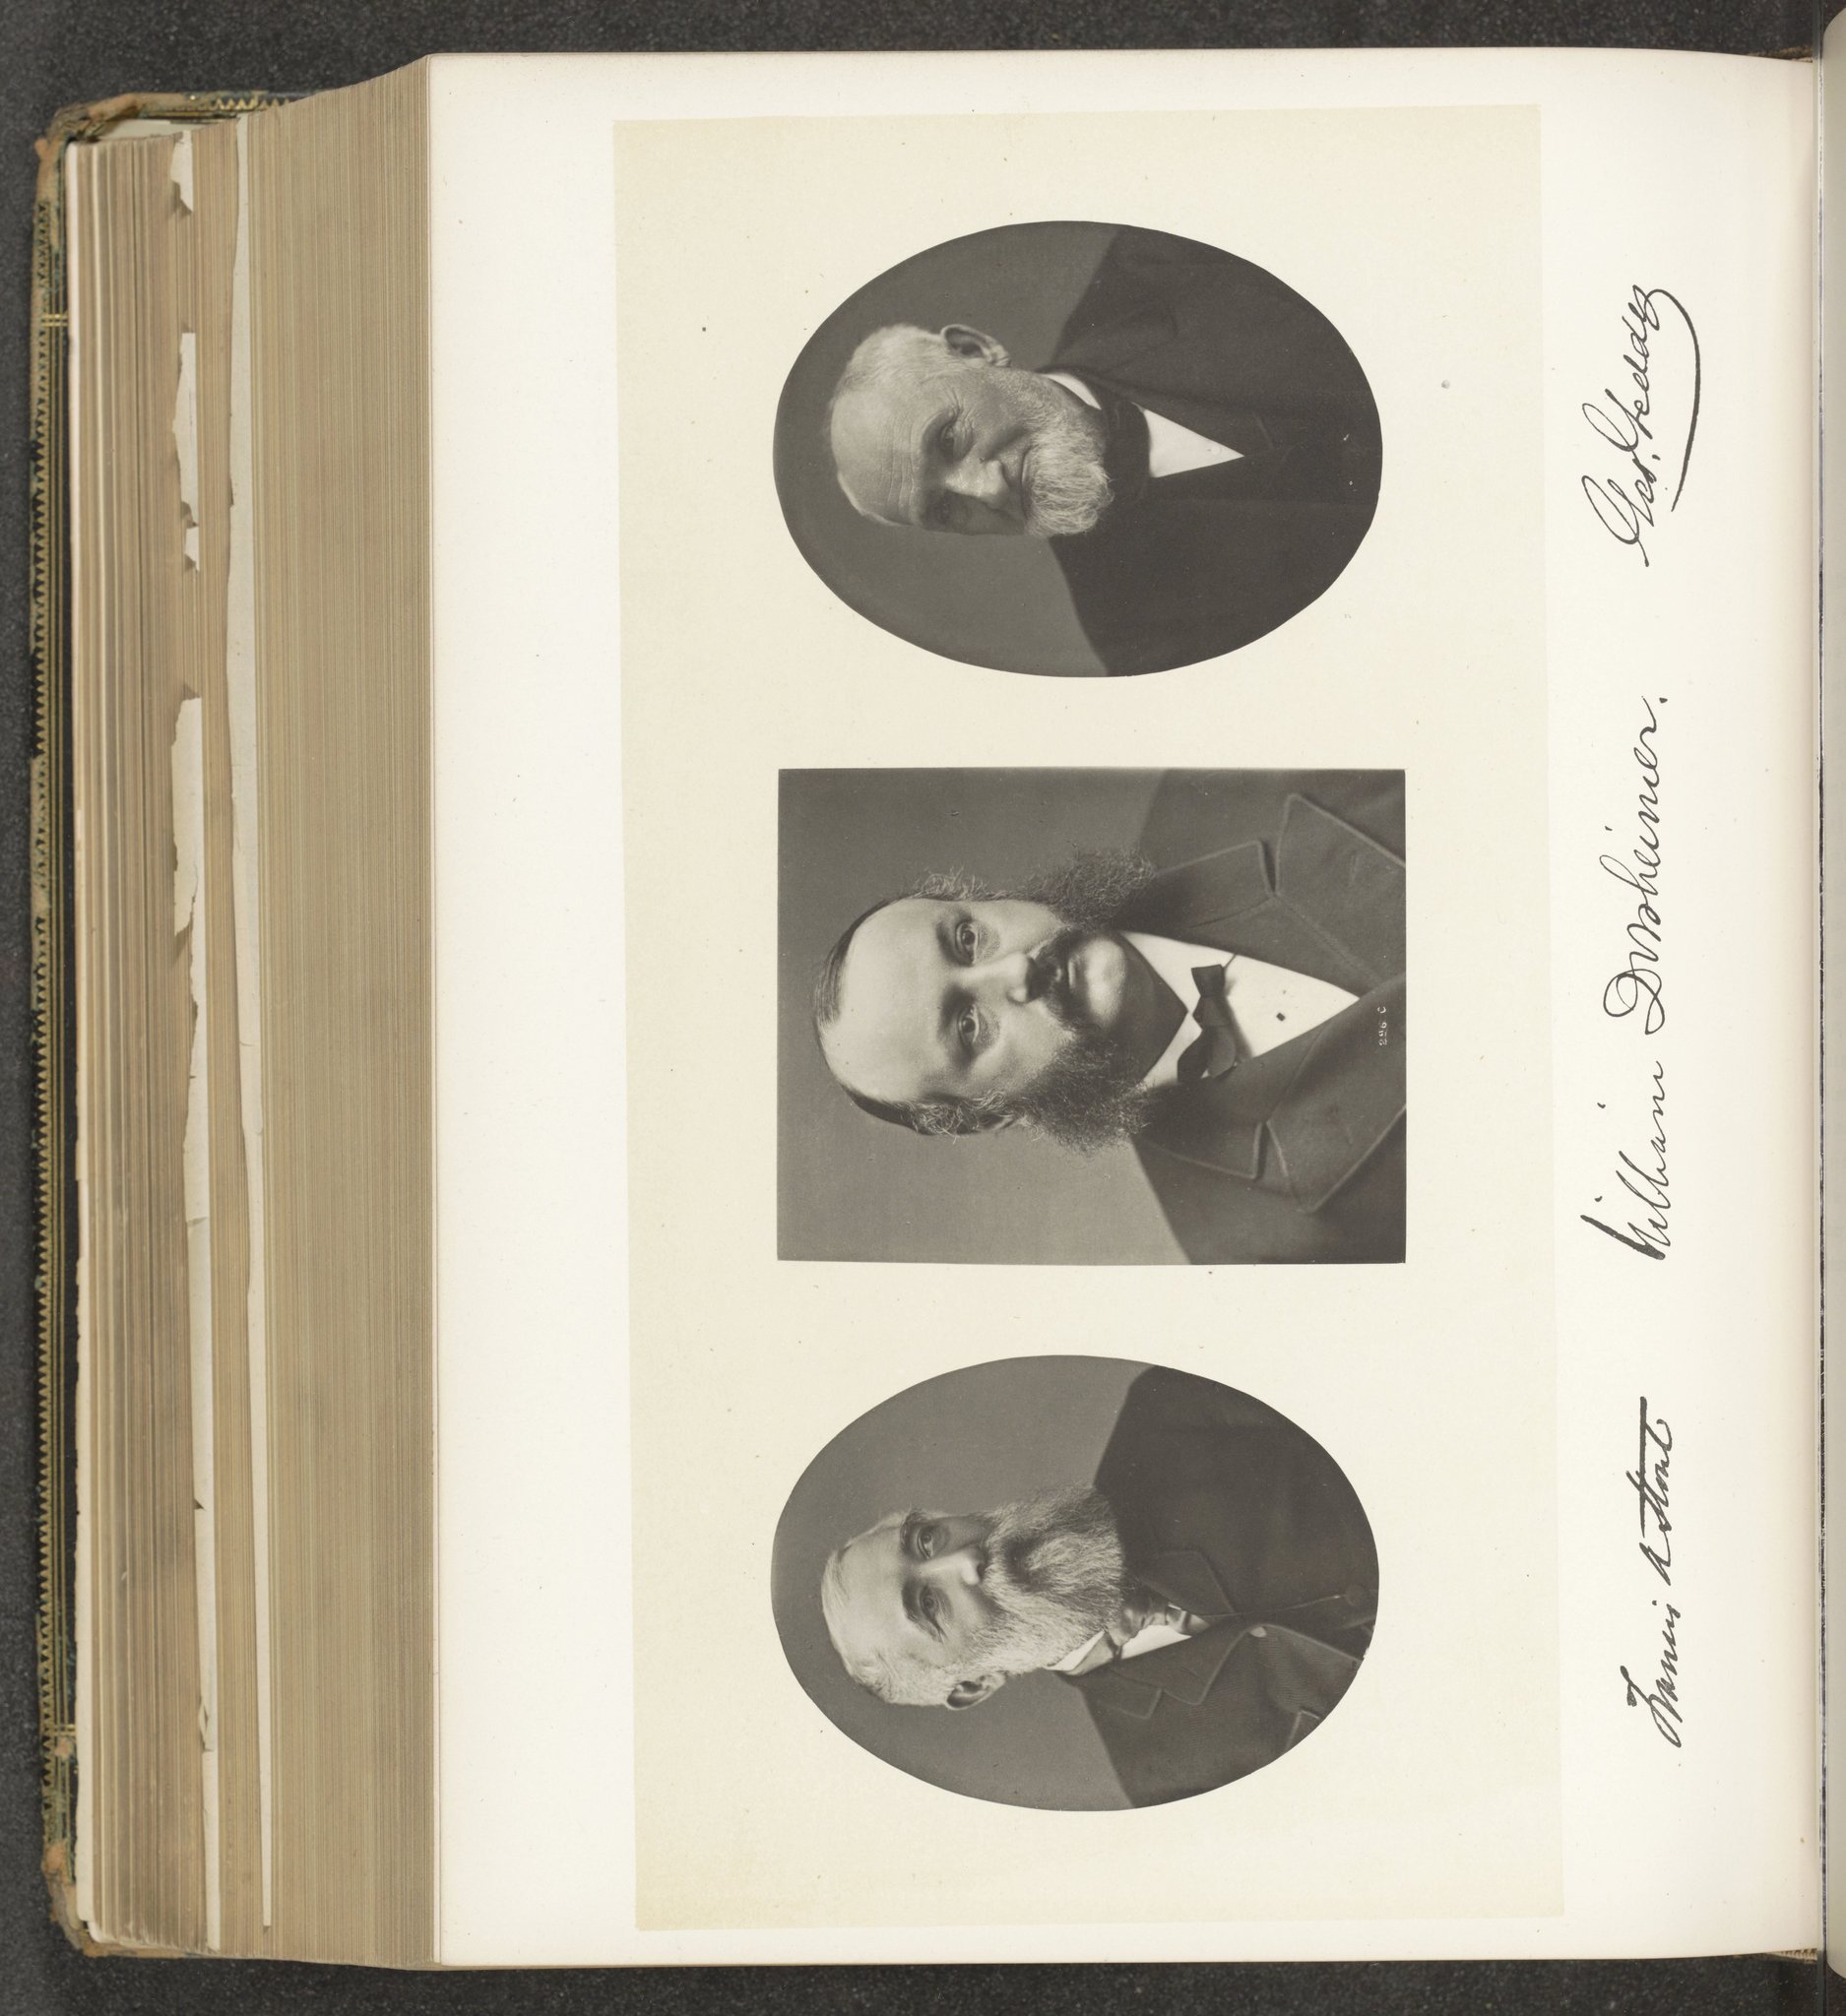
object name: photomechanical print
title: Portretten van drie commissarissen van de staat New York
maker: Anonymous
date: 1872-1882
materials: paper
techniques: photograph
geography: united states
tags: historical persons (portraits and scenes from the life) (+ head (and shoulders) (portrait))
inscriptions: number: ‘226-c’, annotation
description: Links Francis A. Stout, midden William Dorsheimer, rechts George Geddes.